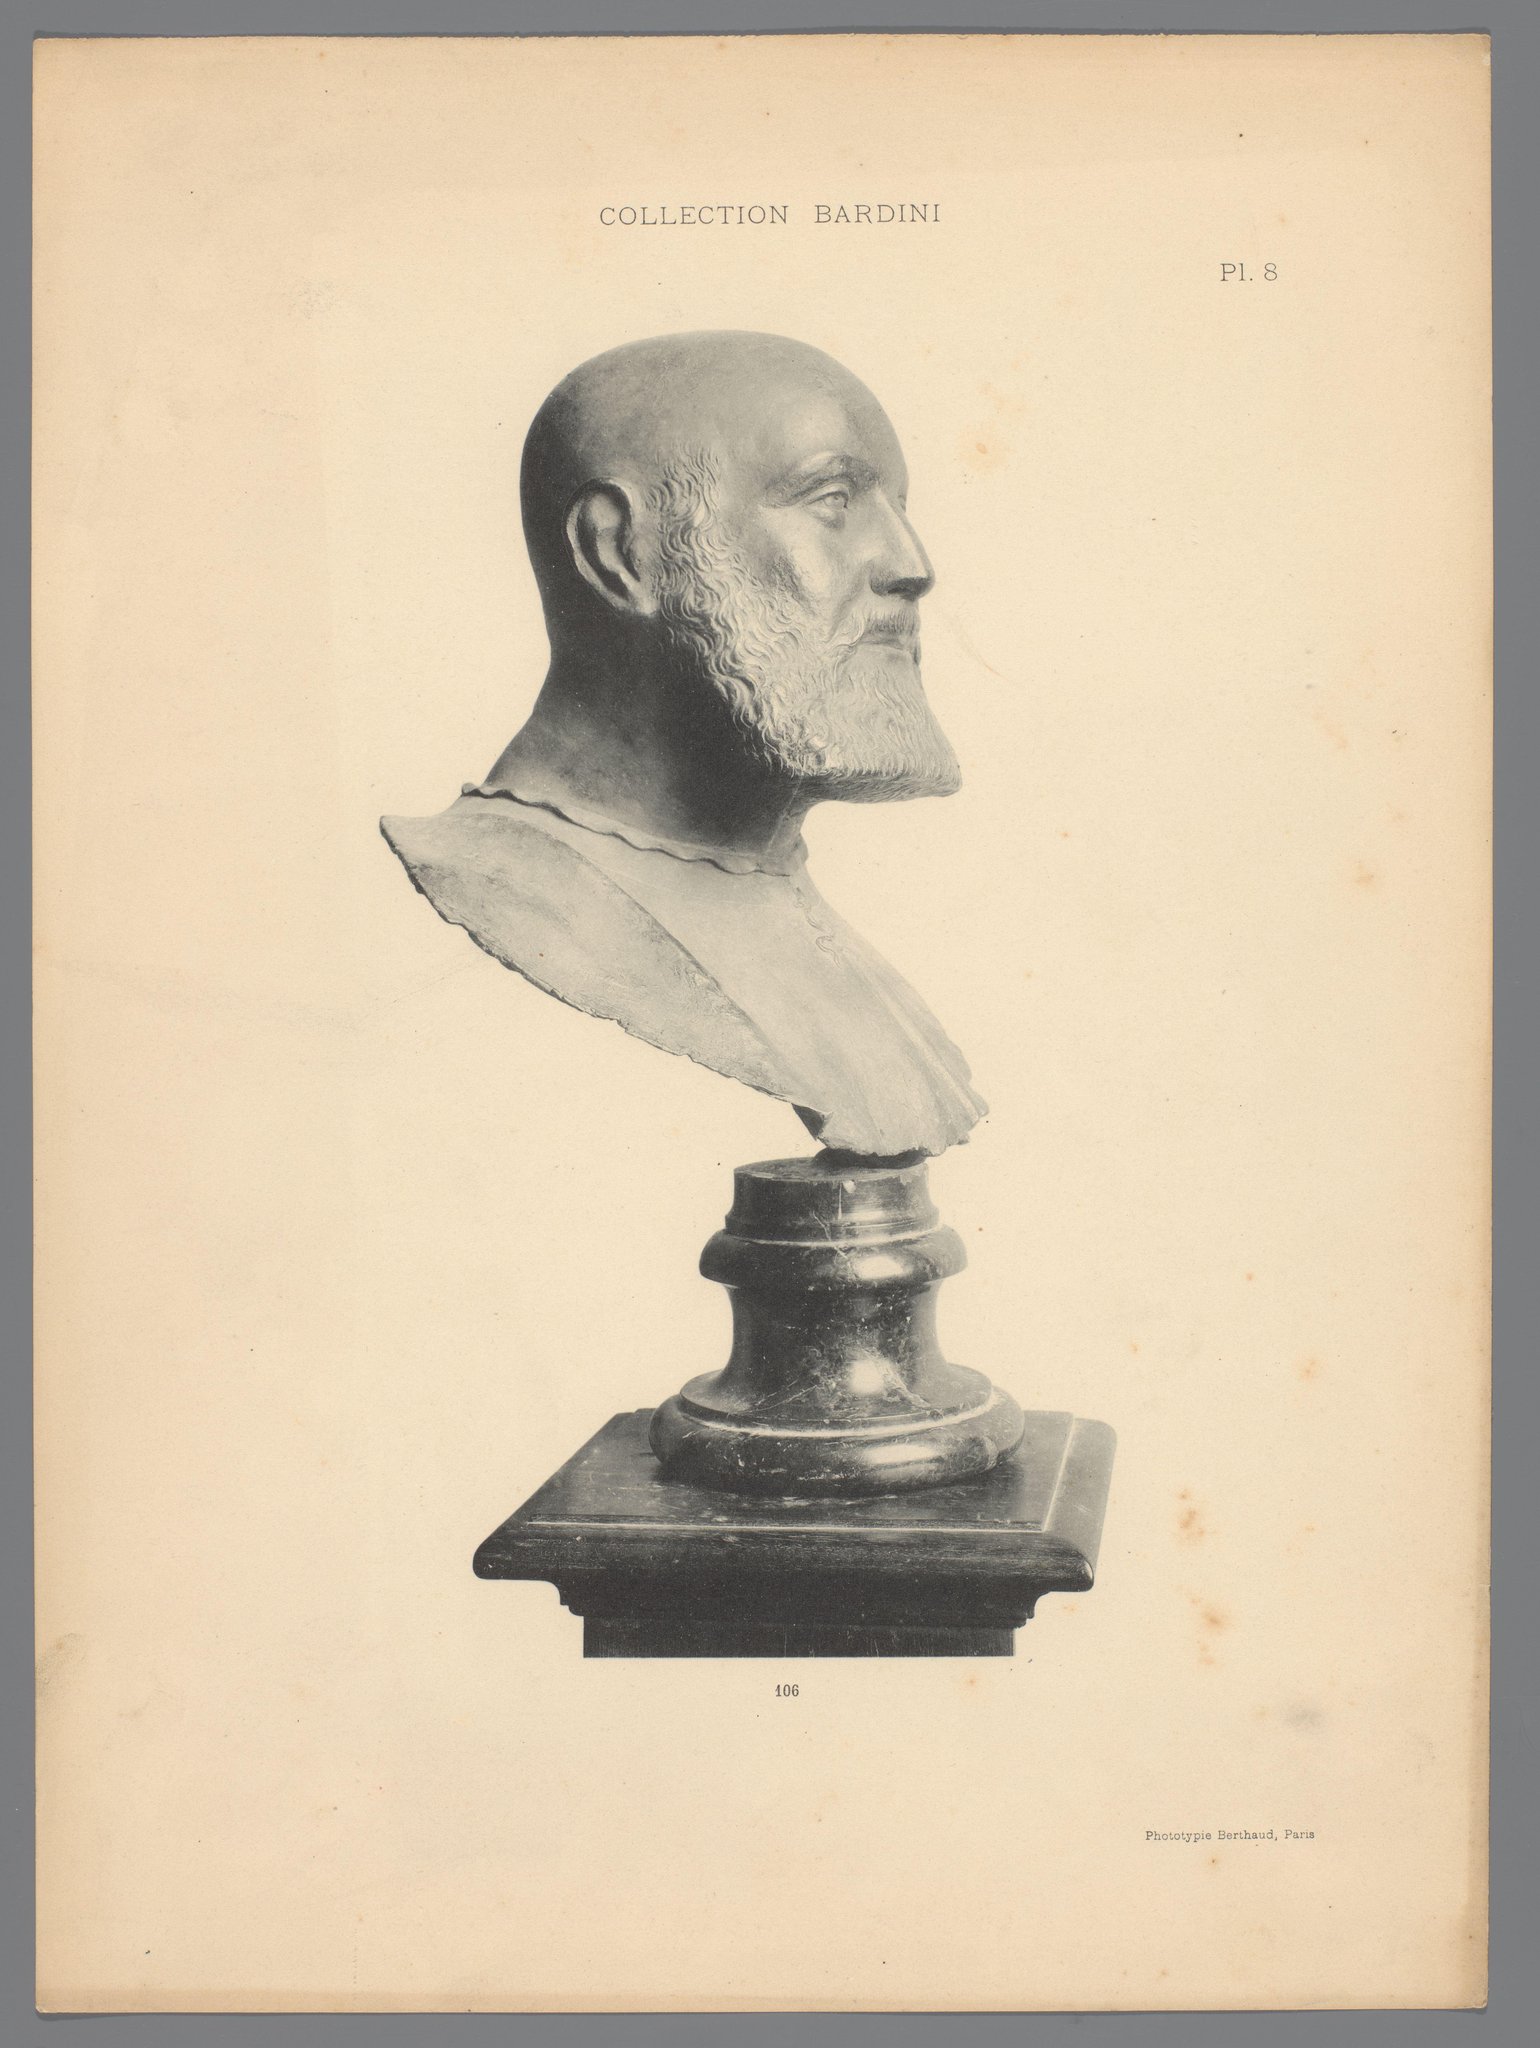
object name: photomechanical print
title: Collection Bardini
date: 1875-1912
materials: paper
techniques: photograph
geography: florence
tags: anonymous historical person portrayed, sculpture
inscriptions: number: ‘Pl. 8’